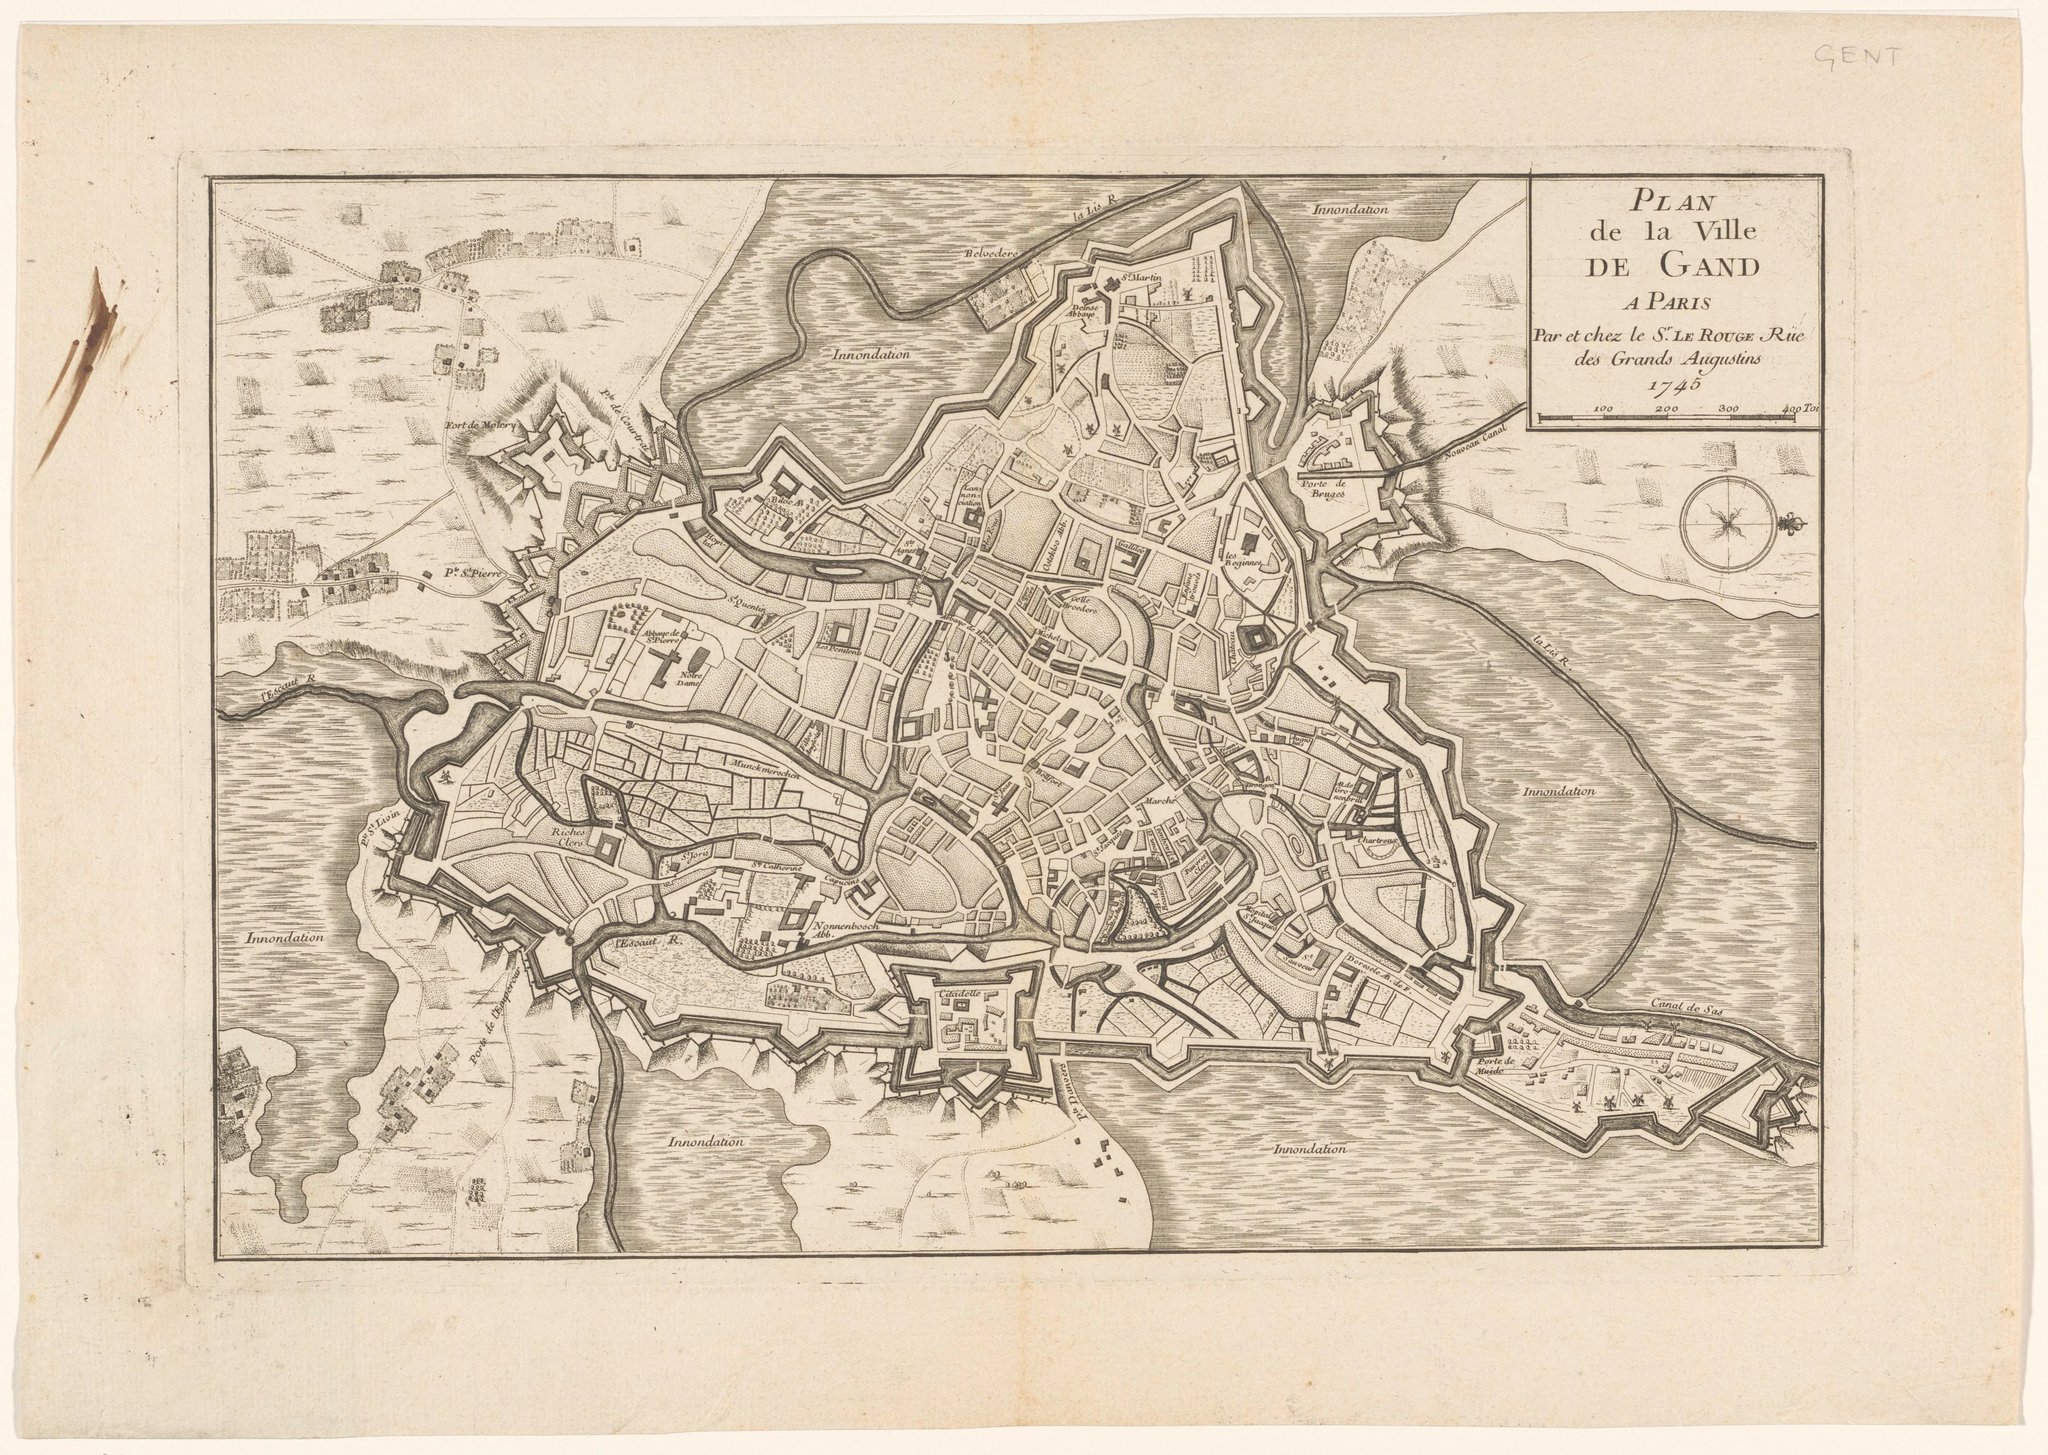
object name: area plan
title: Plattegrond van Gent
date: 1745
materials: paper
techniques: engraving, etching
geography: paris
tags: fortified city, maps of cities, ghent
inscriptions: date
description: Plattegrond van Gent. Rechtsboven een kader met titel en schaalstok: 400 Toises.